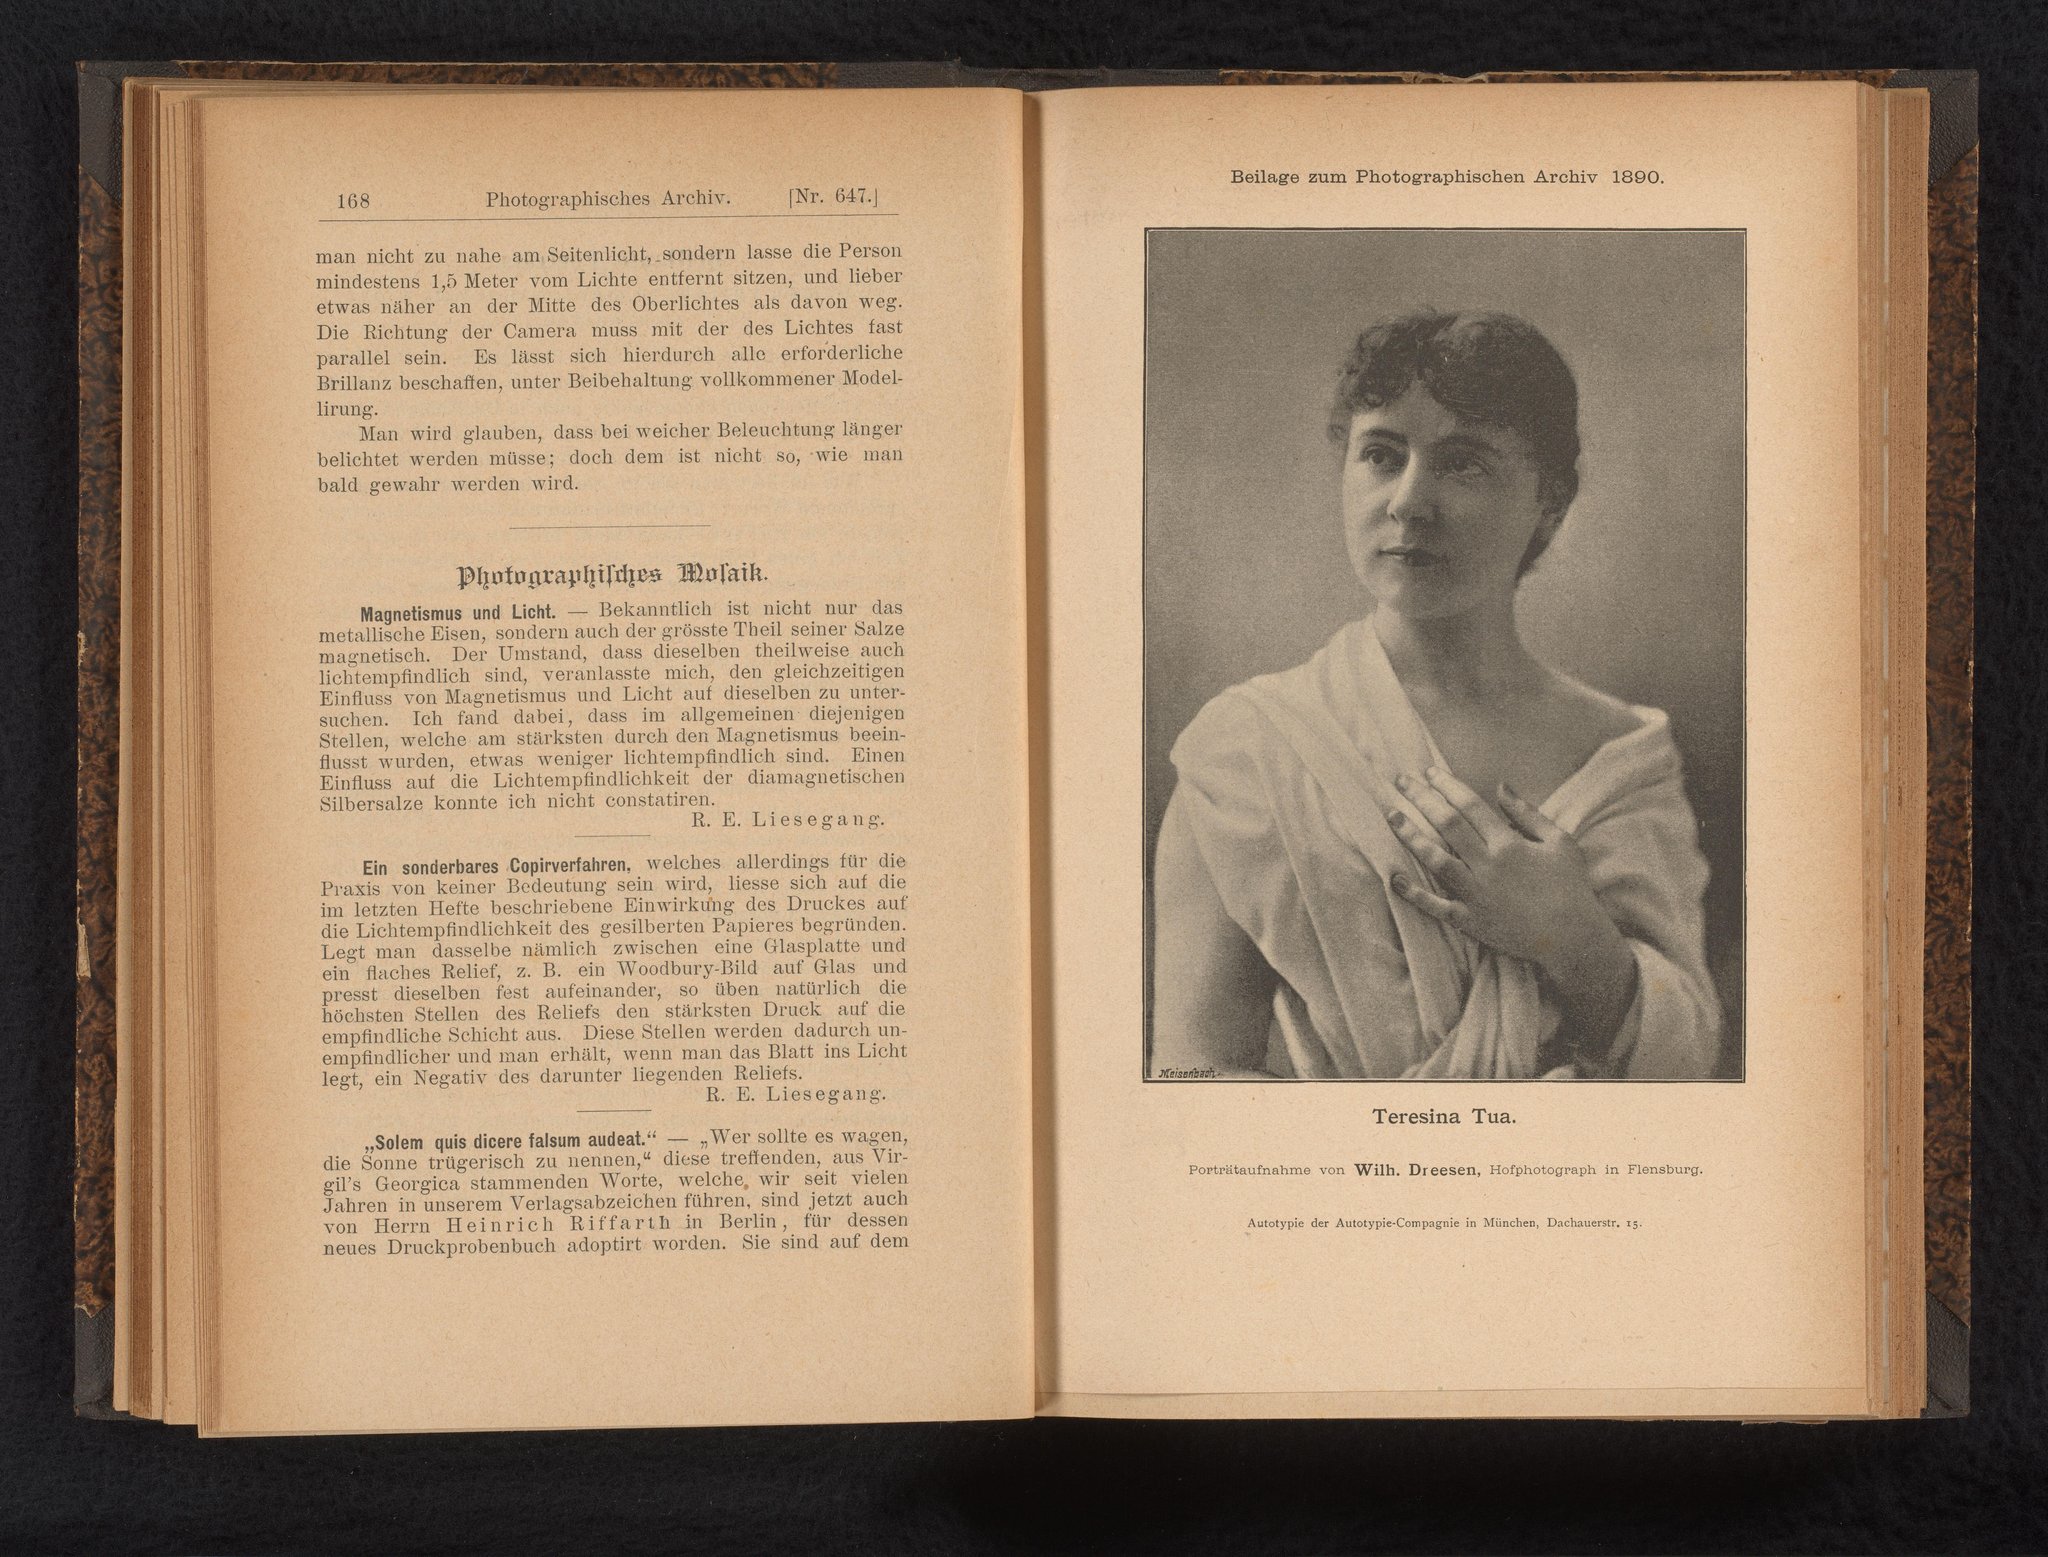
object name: photomechanical print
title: Teresina Tua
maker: wilhelm dreesen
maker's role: fotograaf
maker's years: 1840-1926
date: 1885-1890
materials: paper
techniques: autotype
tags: rome, historical persons - bb - woman, portrait of a musician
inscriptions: signature: ‘Meisenbach’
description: Prent op ongenummerde pagina tegenover pagina 168.